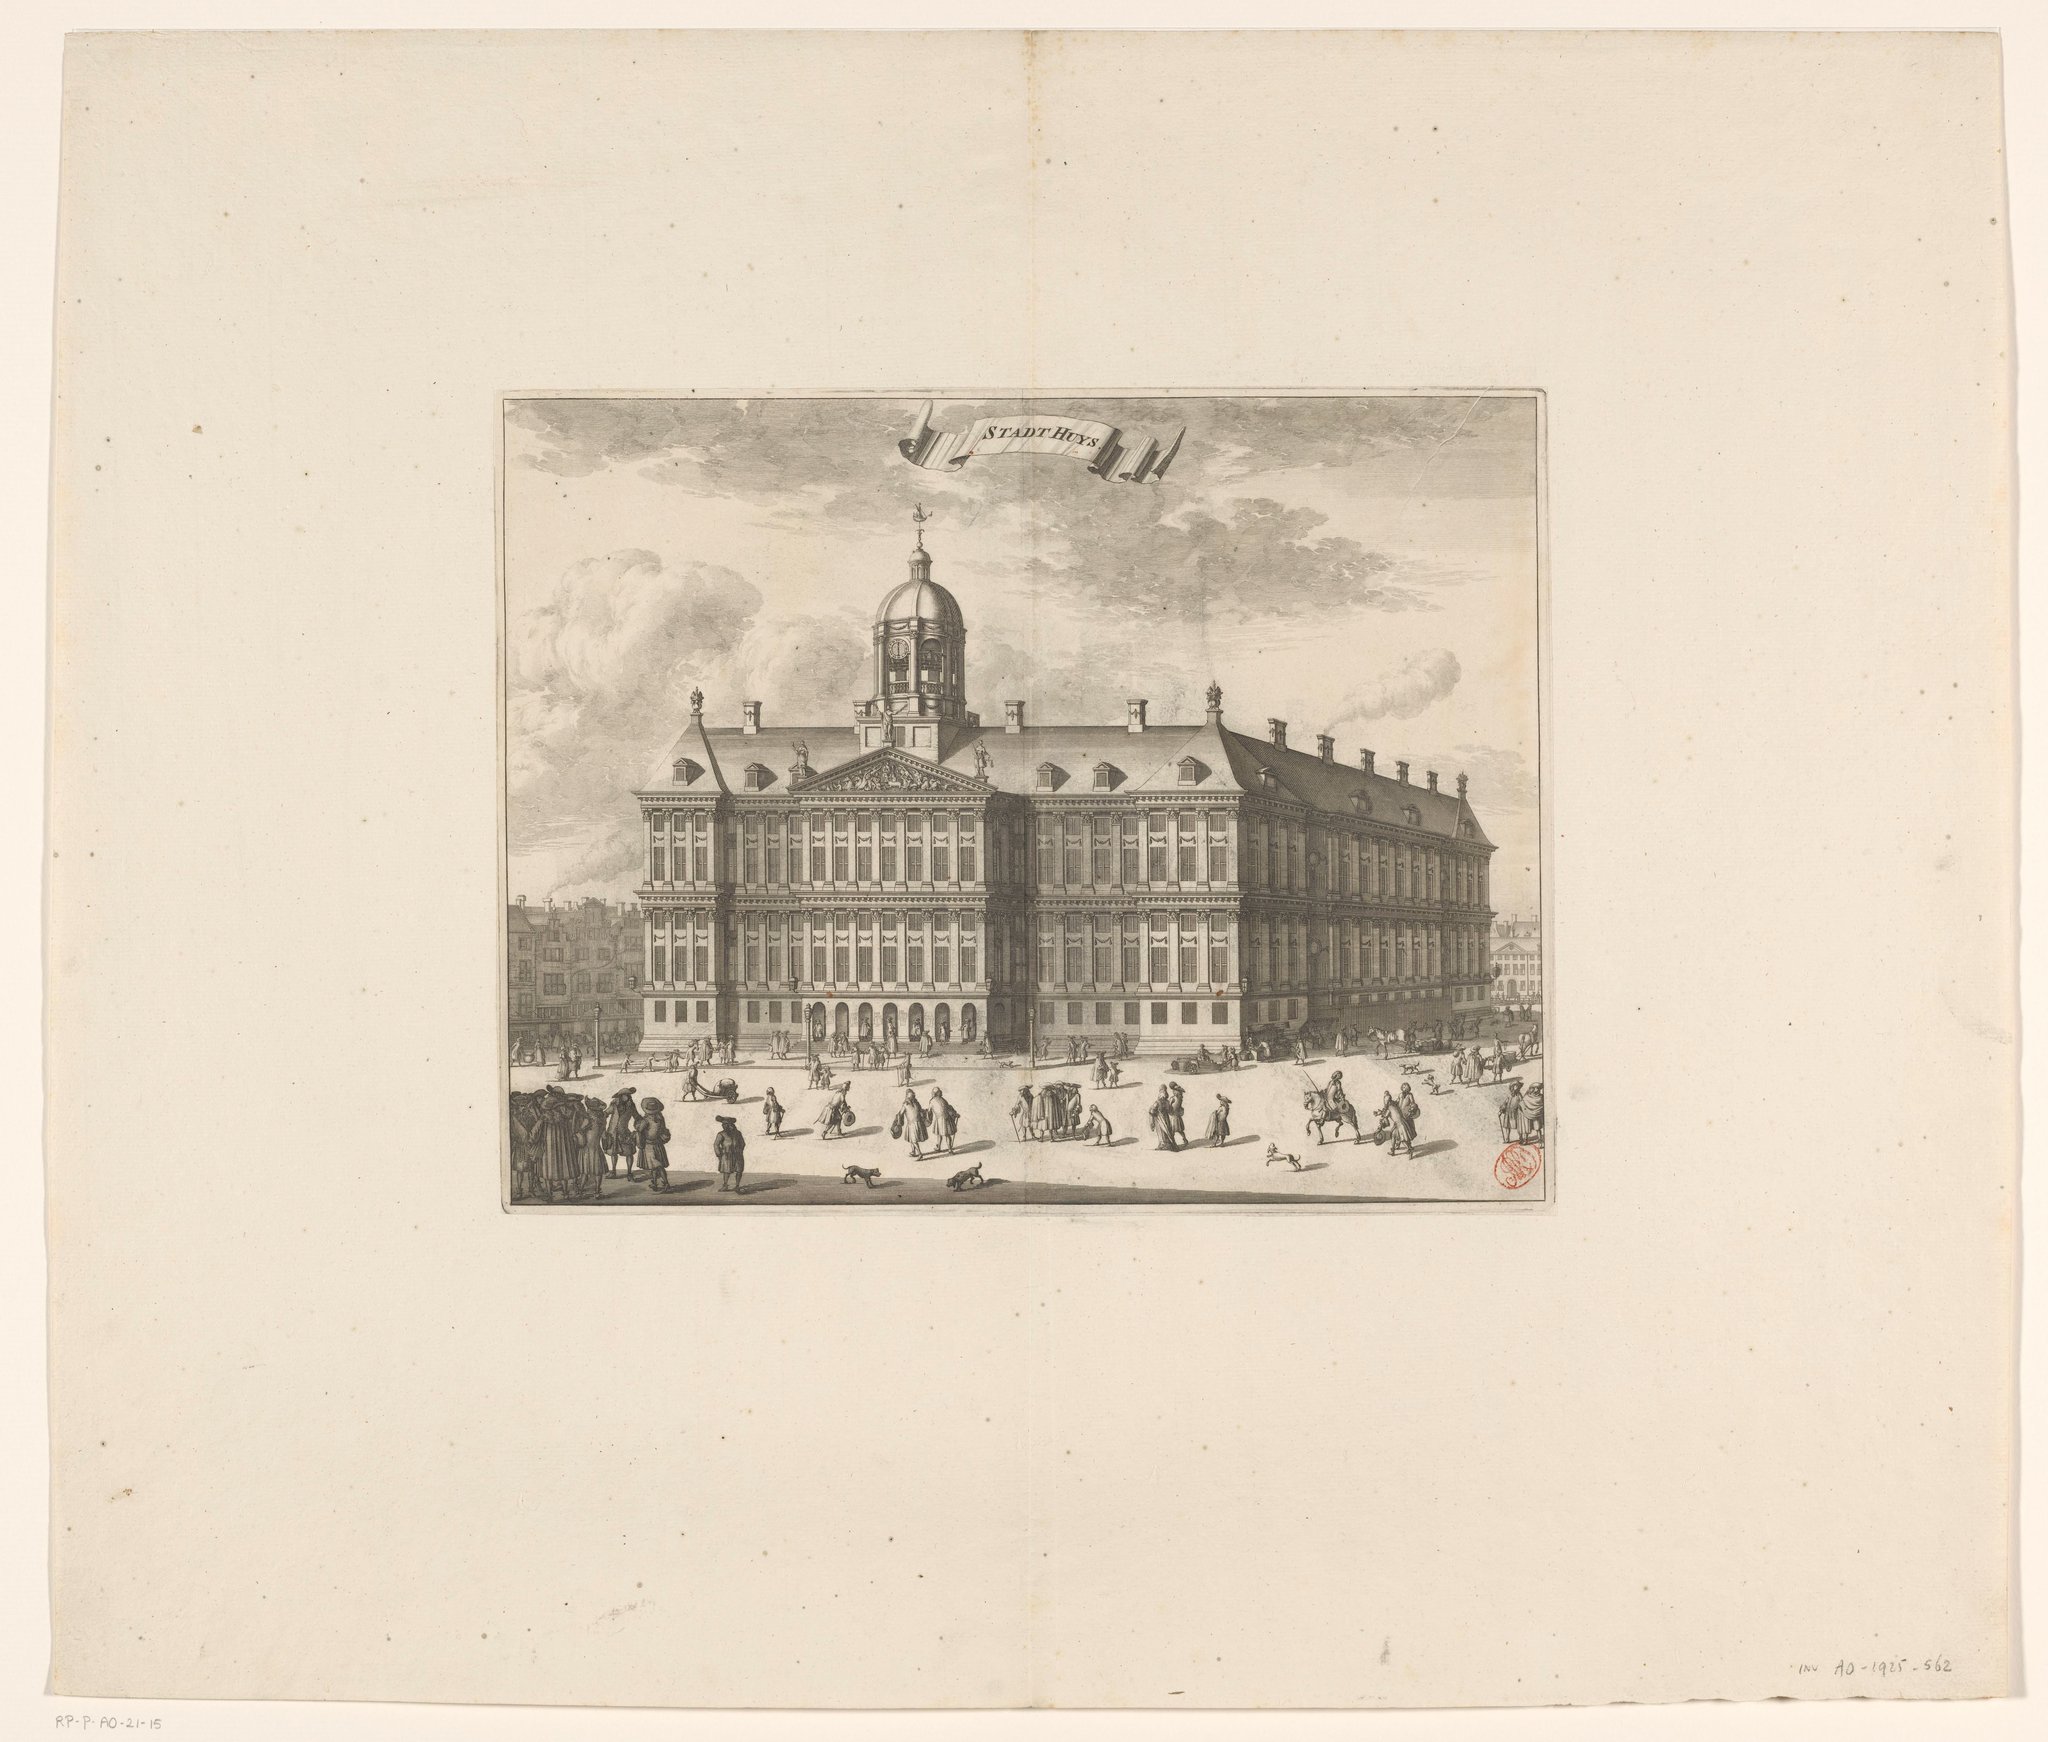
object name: book illustration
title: Stadt Huys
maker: Anonymous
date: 1693-1694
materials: paper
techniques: etching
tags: townhall, square, place, circus, etc. (+ city(-scape) with figures, staffage)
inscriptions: collector's mark: Lugt 195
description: Huidige staat van prent ook gebruikt in: Commelin, Caspar. Beschryvinge van Amsterdam, desselfs eerste oorspronk uyt den Huyse (…). 2 delen. Amsterdam: Abraham Wolfgang, Gillis Janssonius van Waesberge, Johannes Janssonius van Waesberge II, weduwe Dirk Boom I, Hendrick Boom en Rembertus Goethals, 1693. En in: Commelin, Caspar. Beschryvinge van Amsterdam, zynde een naukeurige verhandelinge van desselfs eerste oorspronk uyt (…). 2 delen. Amsterdam: weduwe Aart Dircksz Oossaan, 1694. Latere staat ook gebruikt in: Commelin, Caspar. Beschryvinge van Amsterdam, zynde een naukeurige verhandelinge van desselfs eerste oorspronk uyt (…). 2 delen. 2e druk. Amsterdam: Andries van Damme, Johannes Ratelband, weduwe A. van Aaltwyk en Hermanus Uytwerf, 1726.